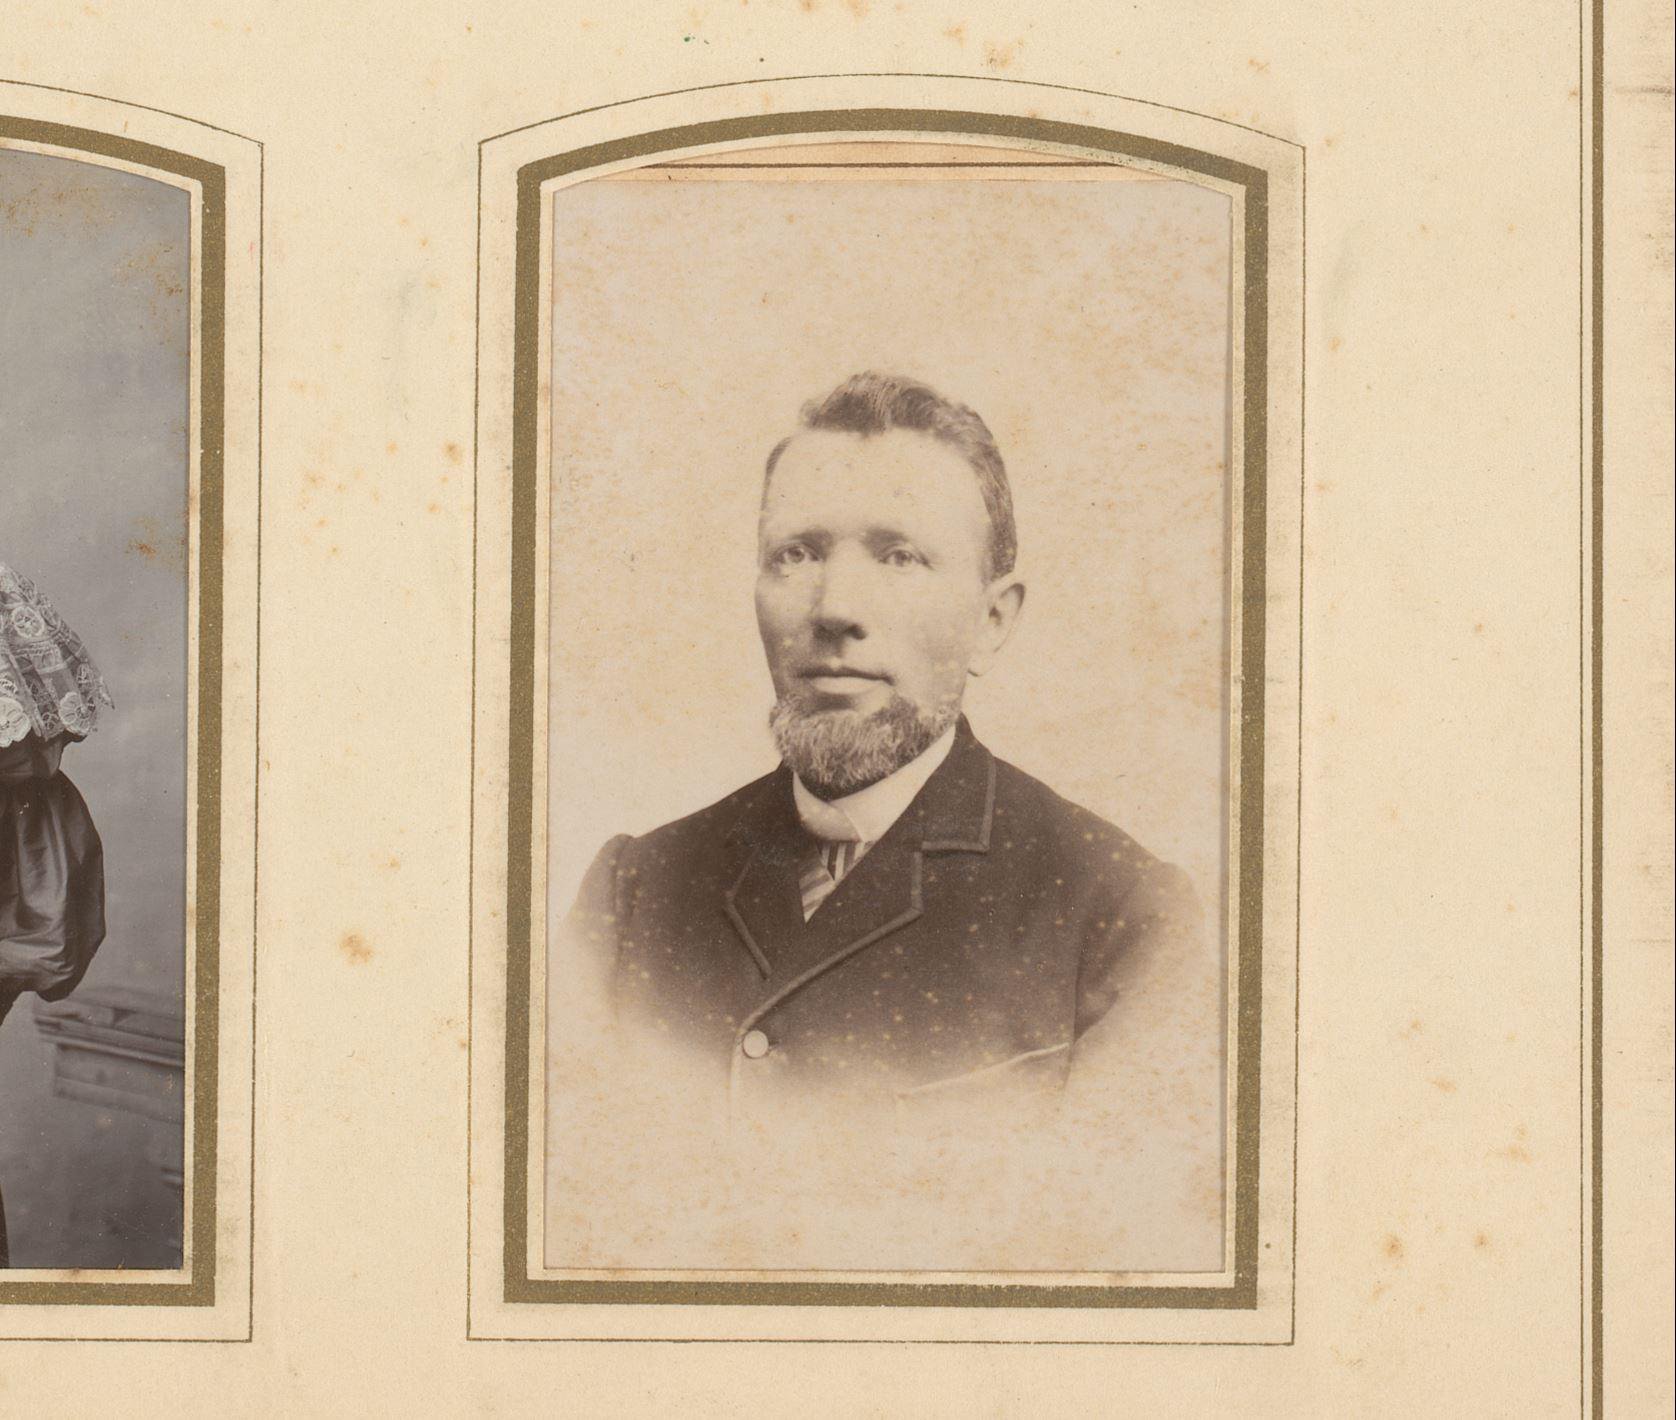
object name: album leaf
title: Portret van een man met baard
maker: elkan sanders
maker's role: fotograaf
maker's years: 1848-1923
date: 1886-1891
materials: cardboard, photographic support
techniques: albumen print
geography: groningen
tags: historical persons, beard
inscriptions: inscription: ‘Elkan Sanders Jr/ Groningen Oosterstraat 204, Hoek Donkersgang./ Vergrootingen naar ieder portret.’